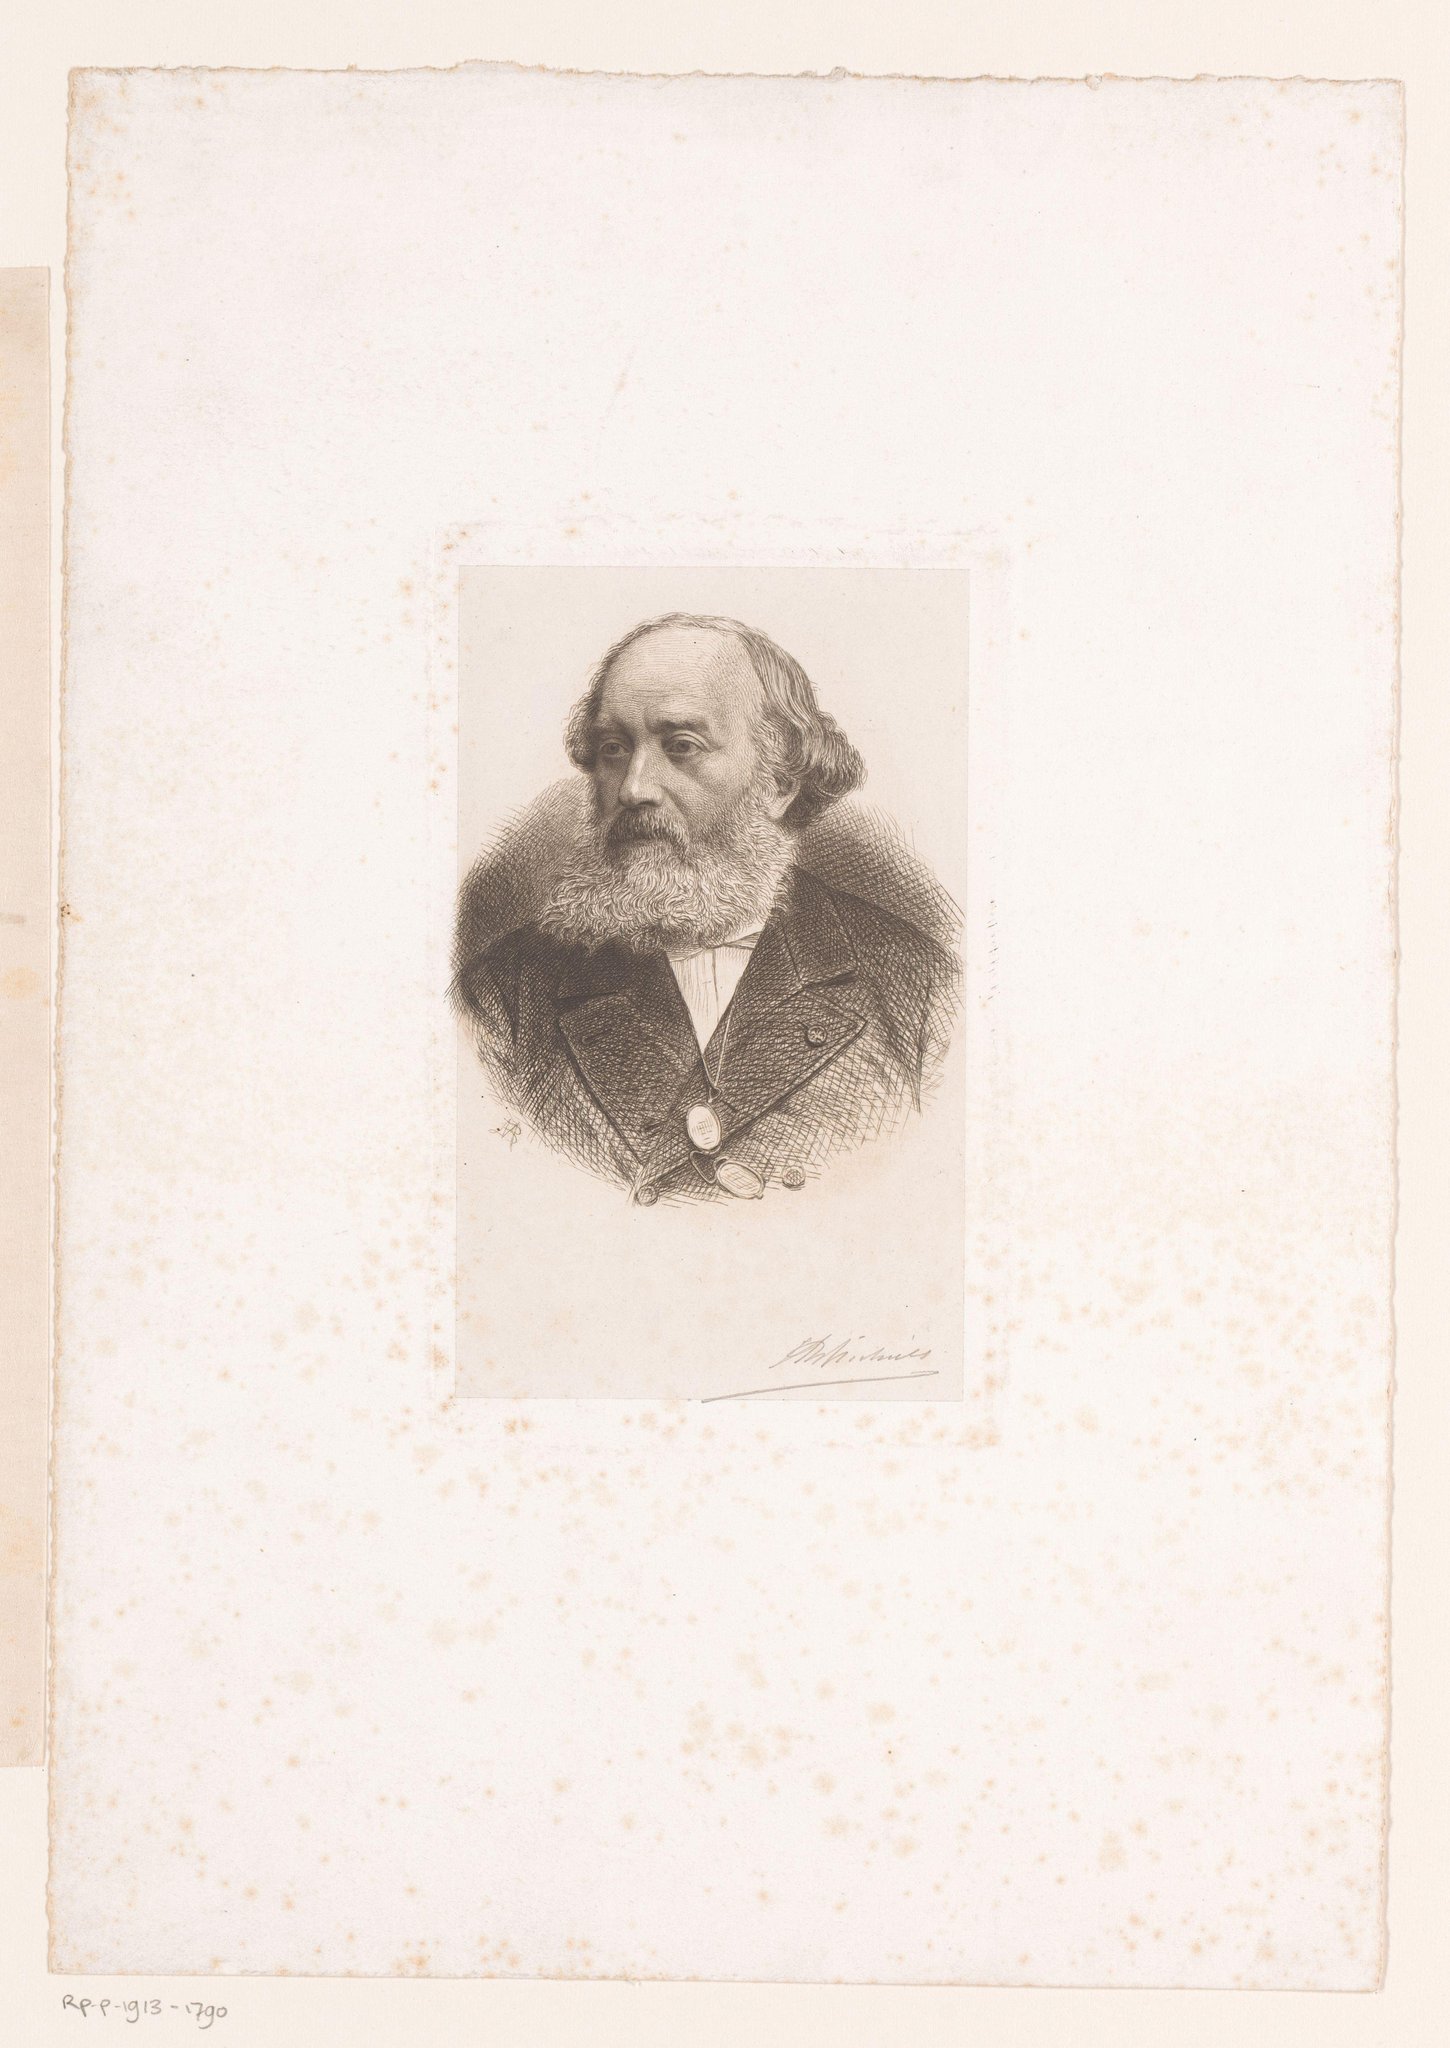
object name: print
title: Portret van Pieter Génard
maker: jean baptiste pierre michiels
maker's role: print maker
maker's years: 1821-1890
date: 1880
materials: paper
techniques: etching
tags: eyeglasses, spectacles, adult man, historical persons, beard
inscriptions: collector's mark: Lugt 2228